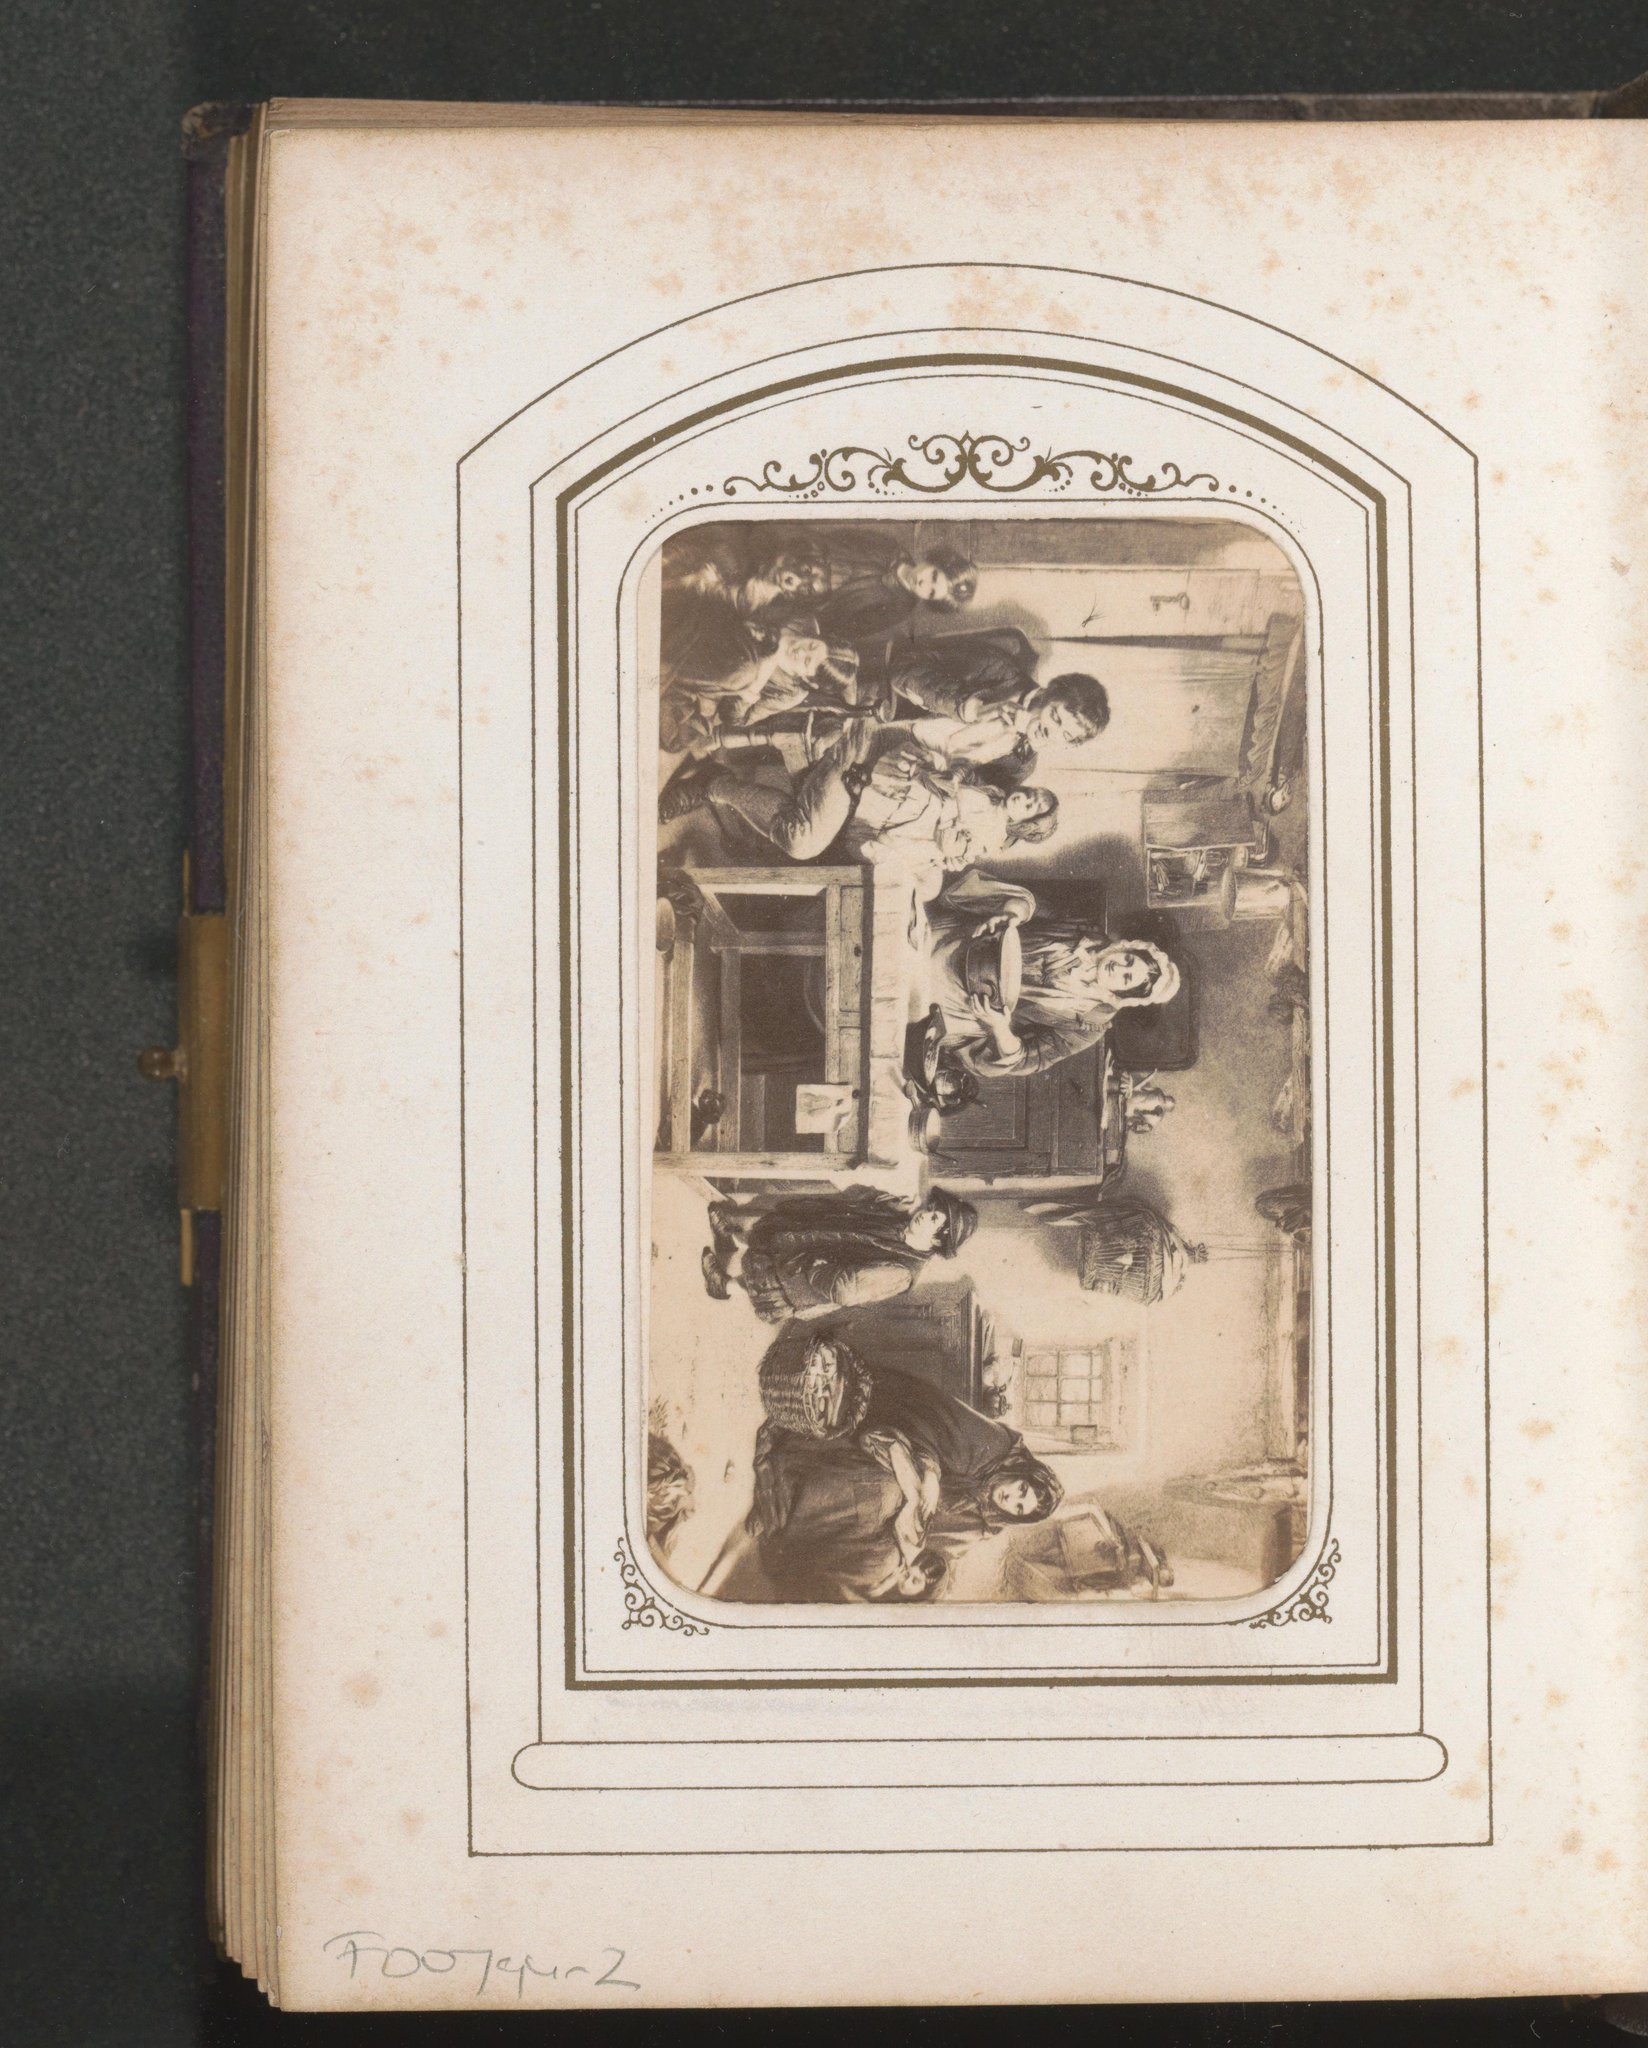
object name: carte de visite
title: Fotoreproductie van (vermoedelijk) een prent naar een schilderij van Tom Faed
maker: Anonymous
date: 1860-1890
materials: cardboard, paper, photographic support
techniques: albumen print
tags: interior of the house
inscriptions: number: ‘55’, inscription: ‘Home and the homeless’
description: Onderdeel van Fotoalbum met 36 opnames van Europese landen.